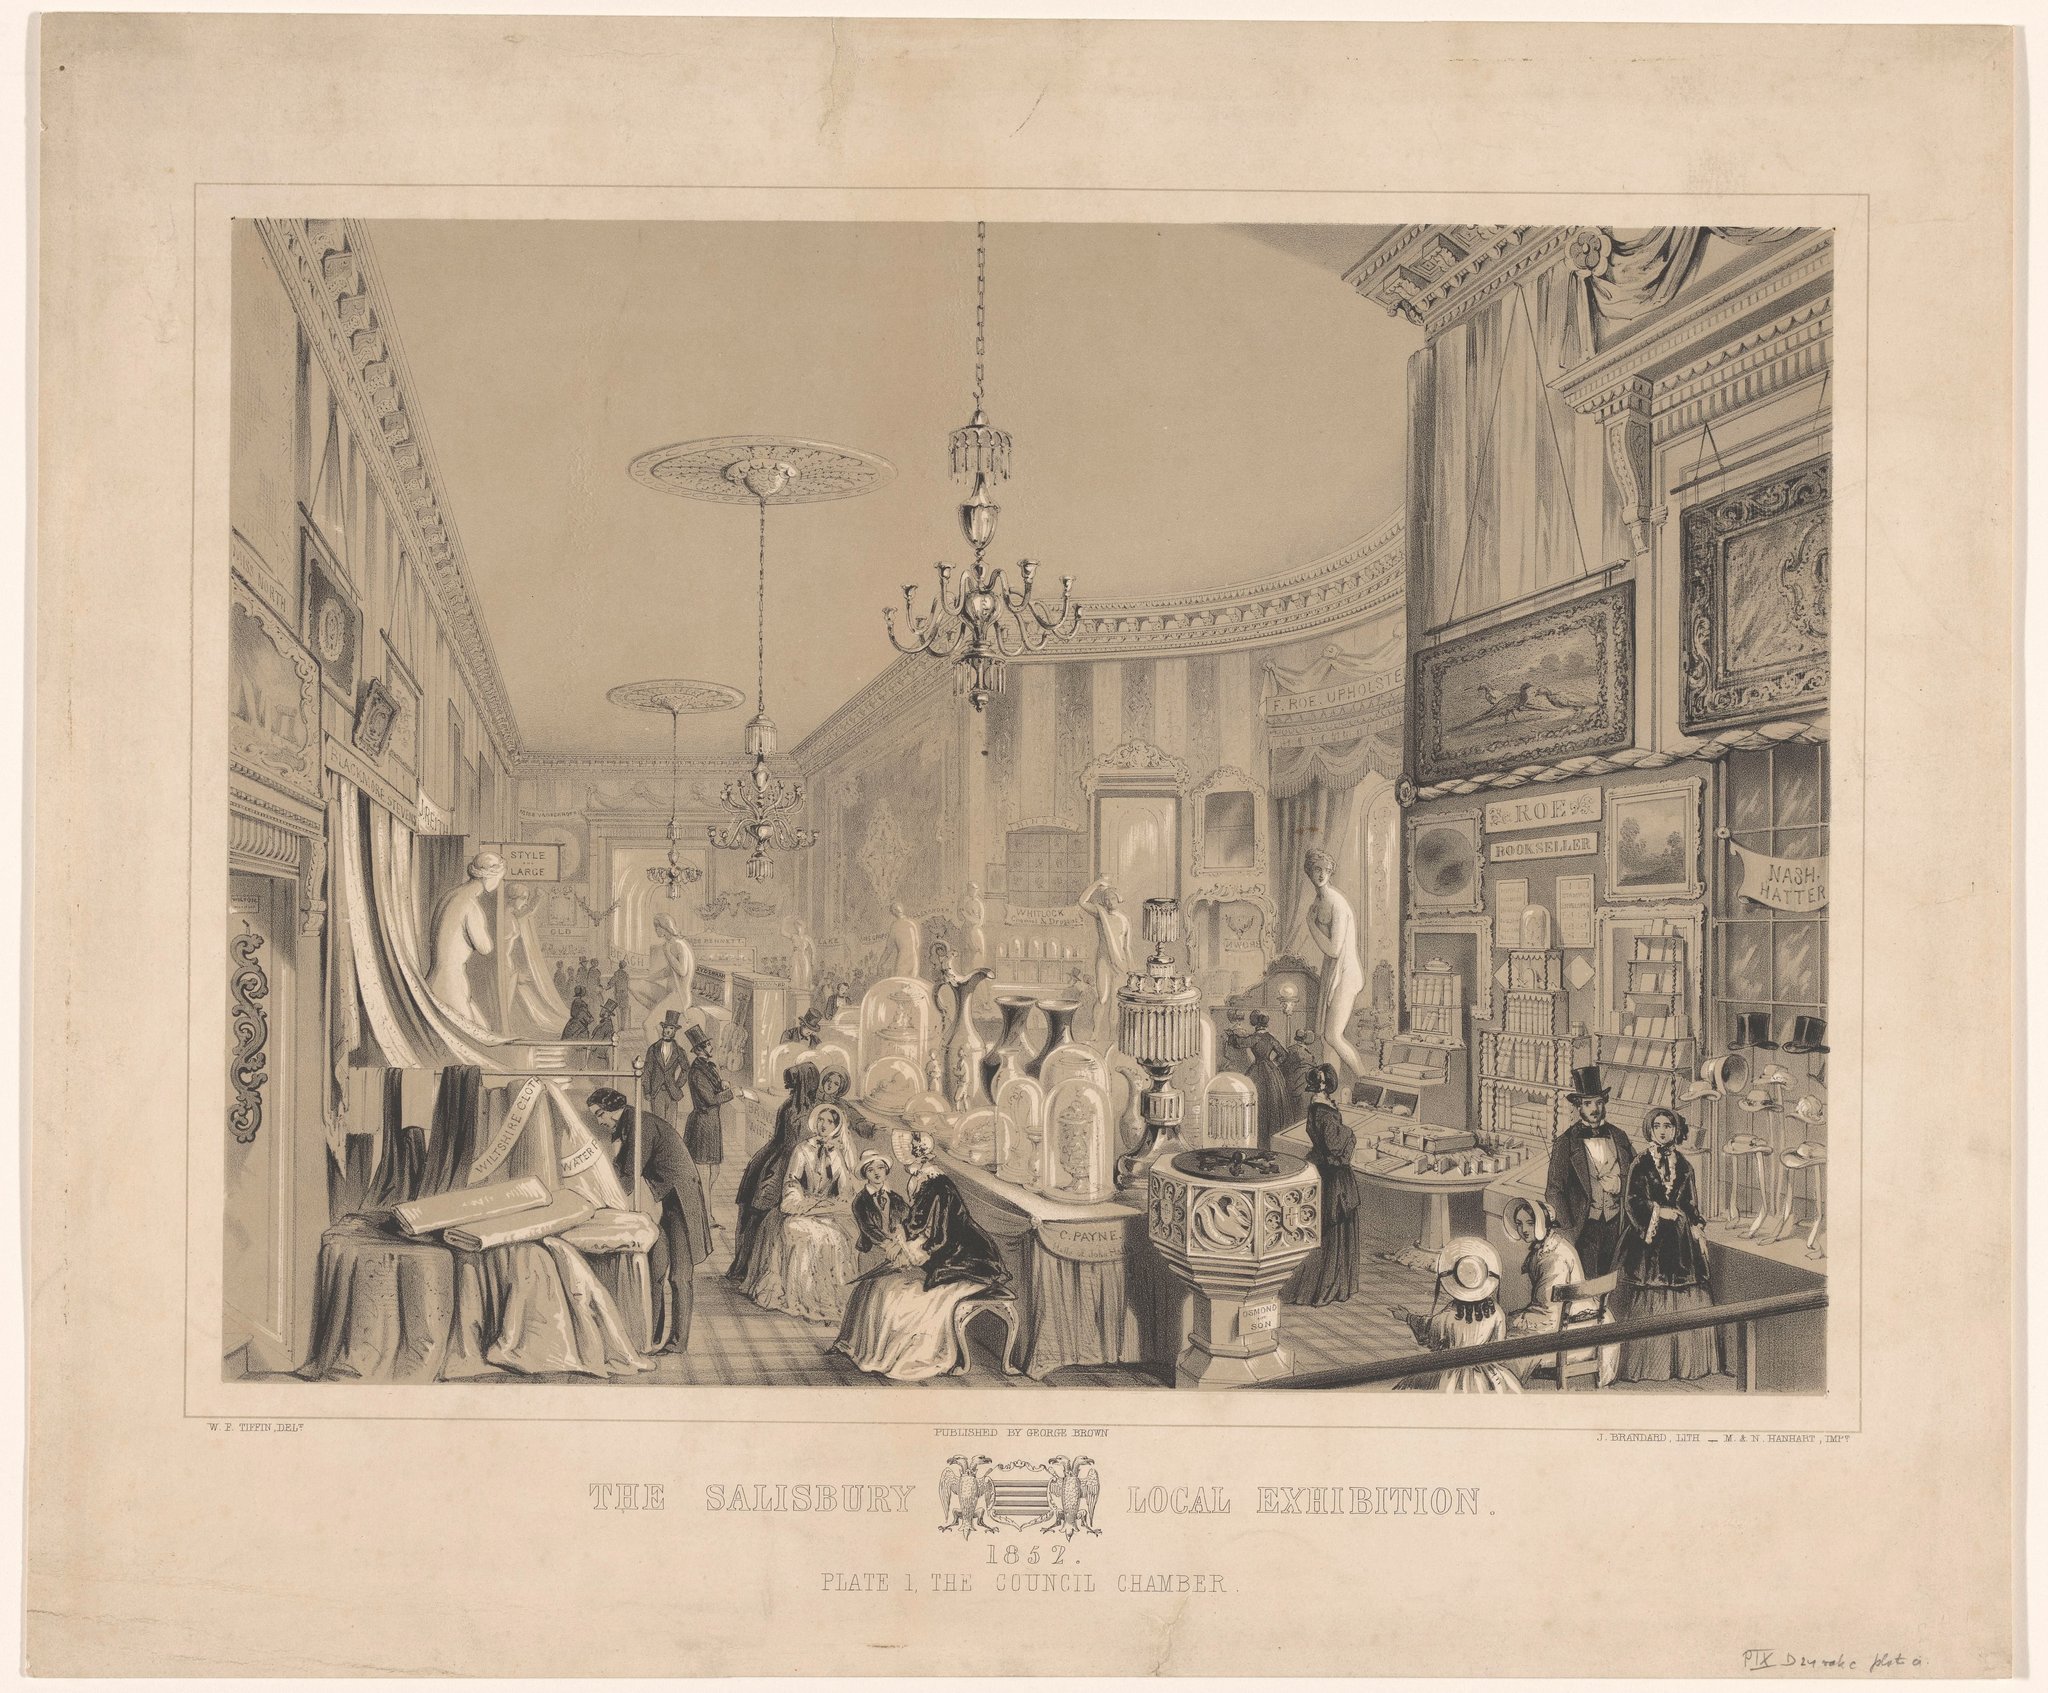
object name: print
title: The Salisbury Local Exhibition 1852. Plate 1, the Council Chamber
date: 1852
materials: paper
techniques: tone lithography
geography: salisbury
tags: book-stall, kiosk, trade exhibition, industries fair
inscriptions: collector's mark: Lugt 4780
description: Interieur met mannen, vrouwen en kinderen die de uitgestalde producten bekijken. Rechts de stand van boekhandel Roe, waarschijnlijk Edward Roe uit Salisbury. Onder het wapen van Salisbury.